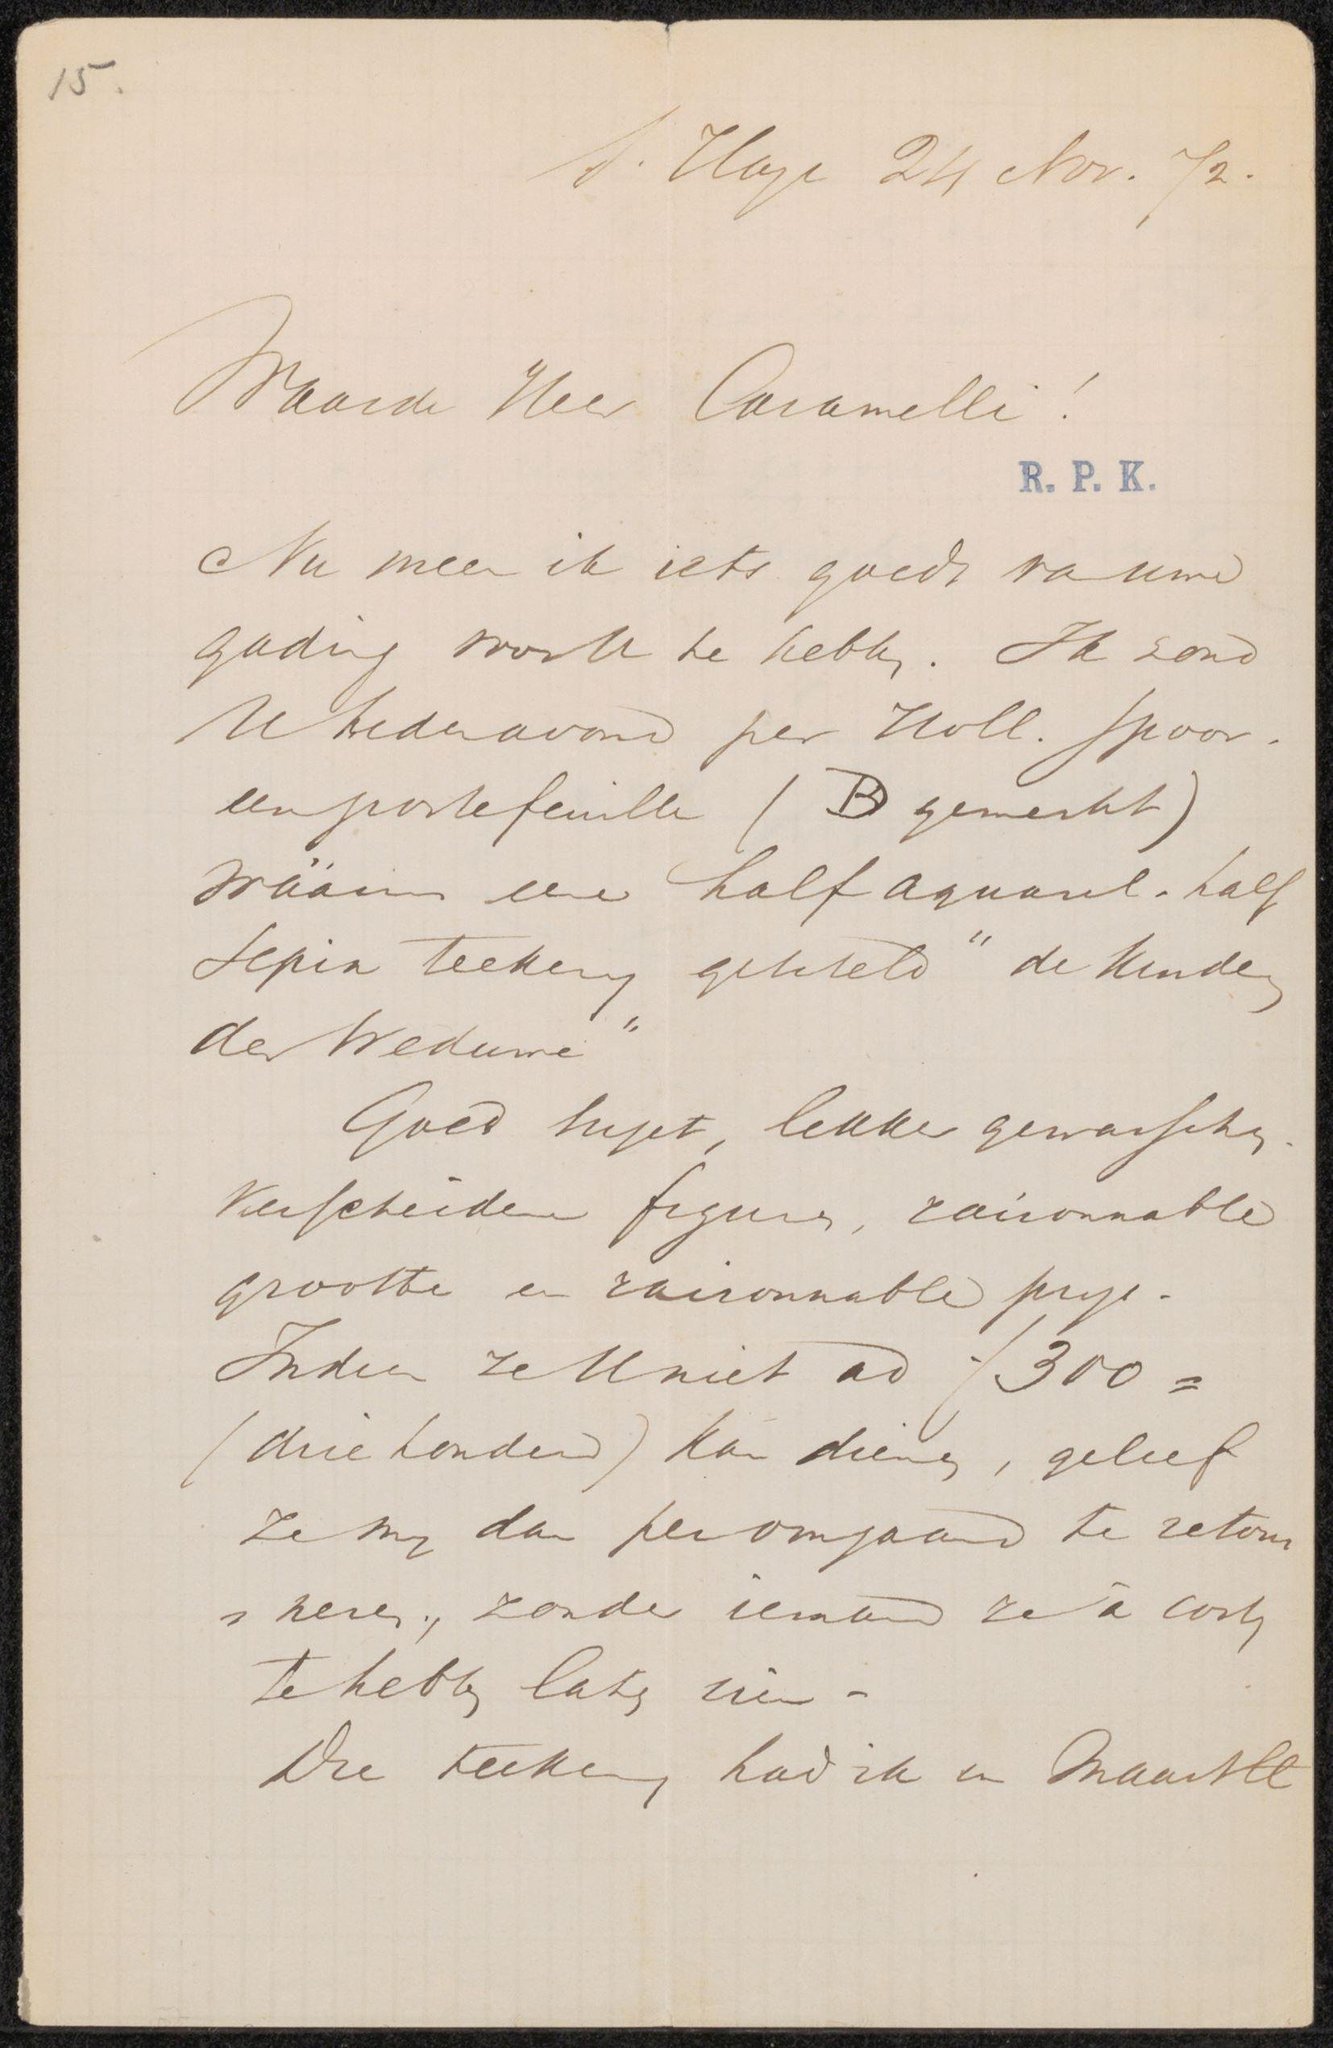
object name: letter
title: Brief aan Alberto Caramelli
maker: david bles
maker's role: draughtsman, painter, print maker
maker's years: 1821-1899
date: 1872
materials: ink, paper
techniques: pen, writing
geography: the hague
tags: utrecht, amsterdam, publisher, alberto caramelli, art trade, art shop, drawing, money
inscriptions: collector's mark: Lugt 2233